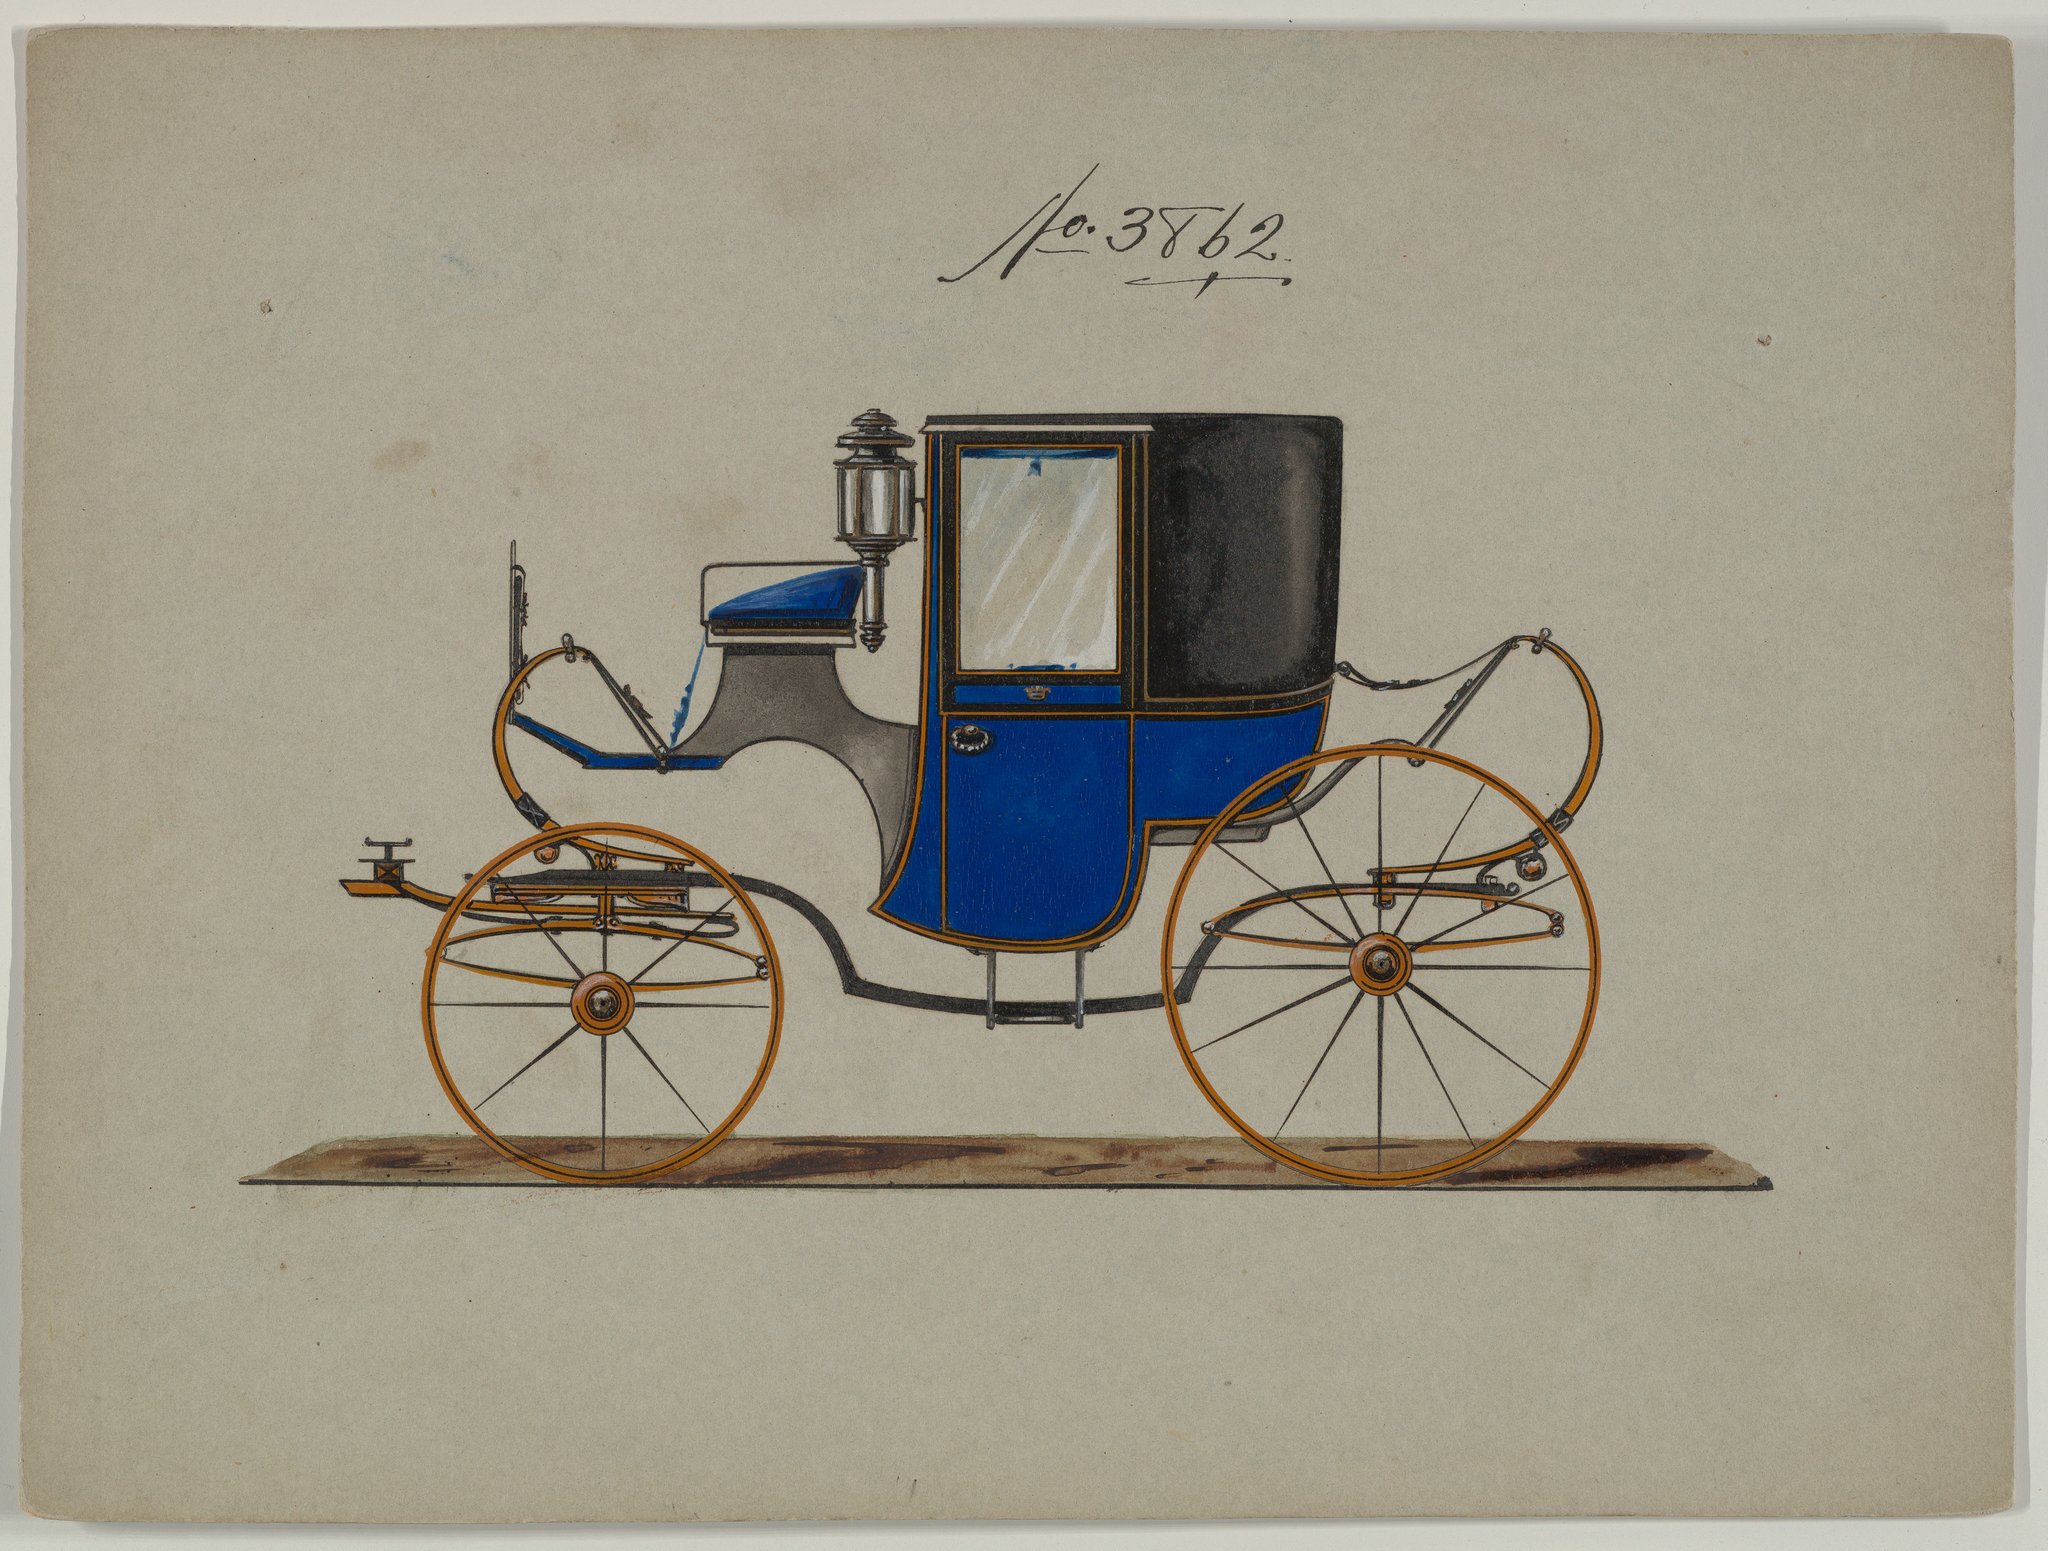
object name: drawing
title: Brougham/D'Orsay #3862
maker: brewster & co.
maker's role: manufacturer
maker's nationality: american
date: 1883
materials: gouache, gum arabic, ink, watercolor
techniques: pen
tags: carriages